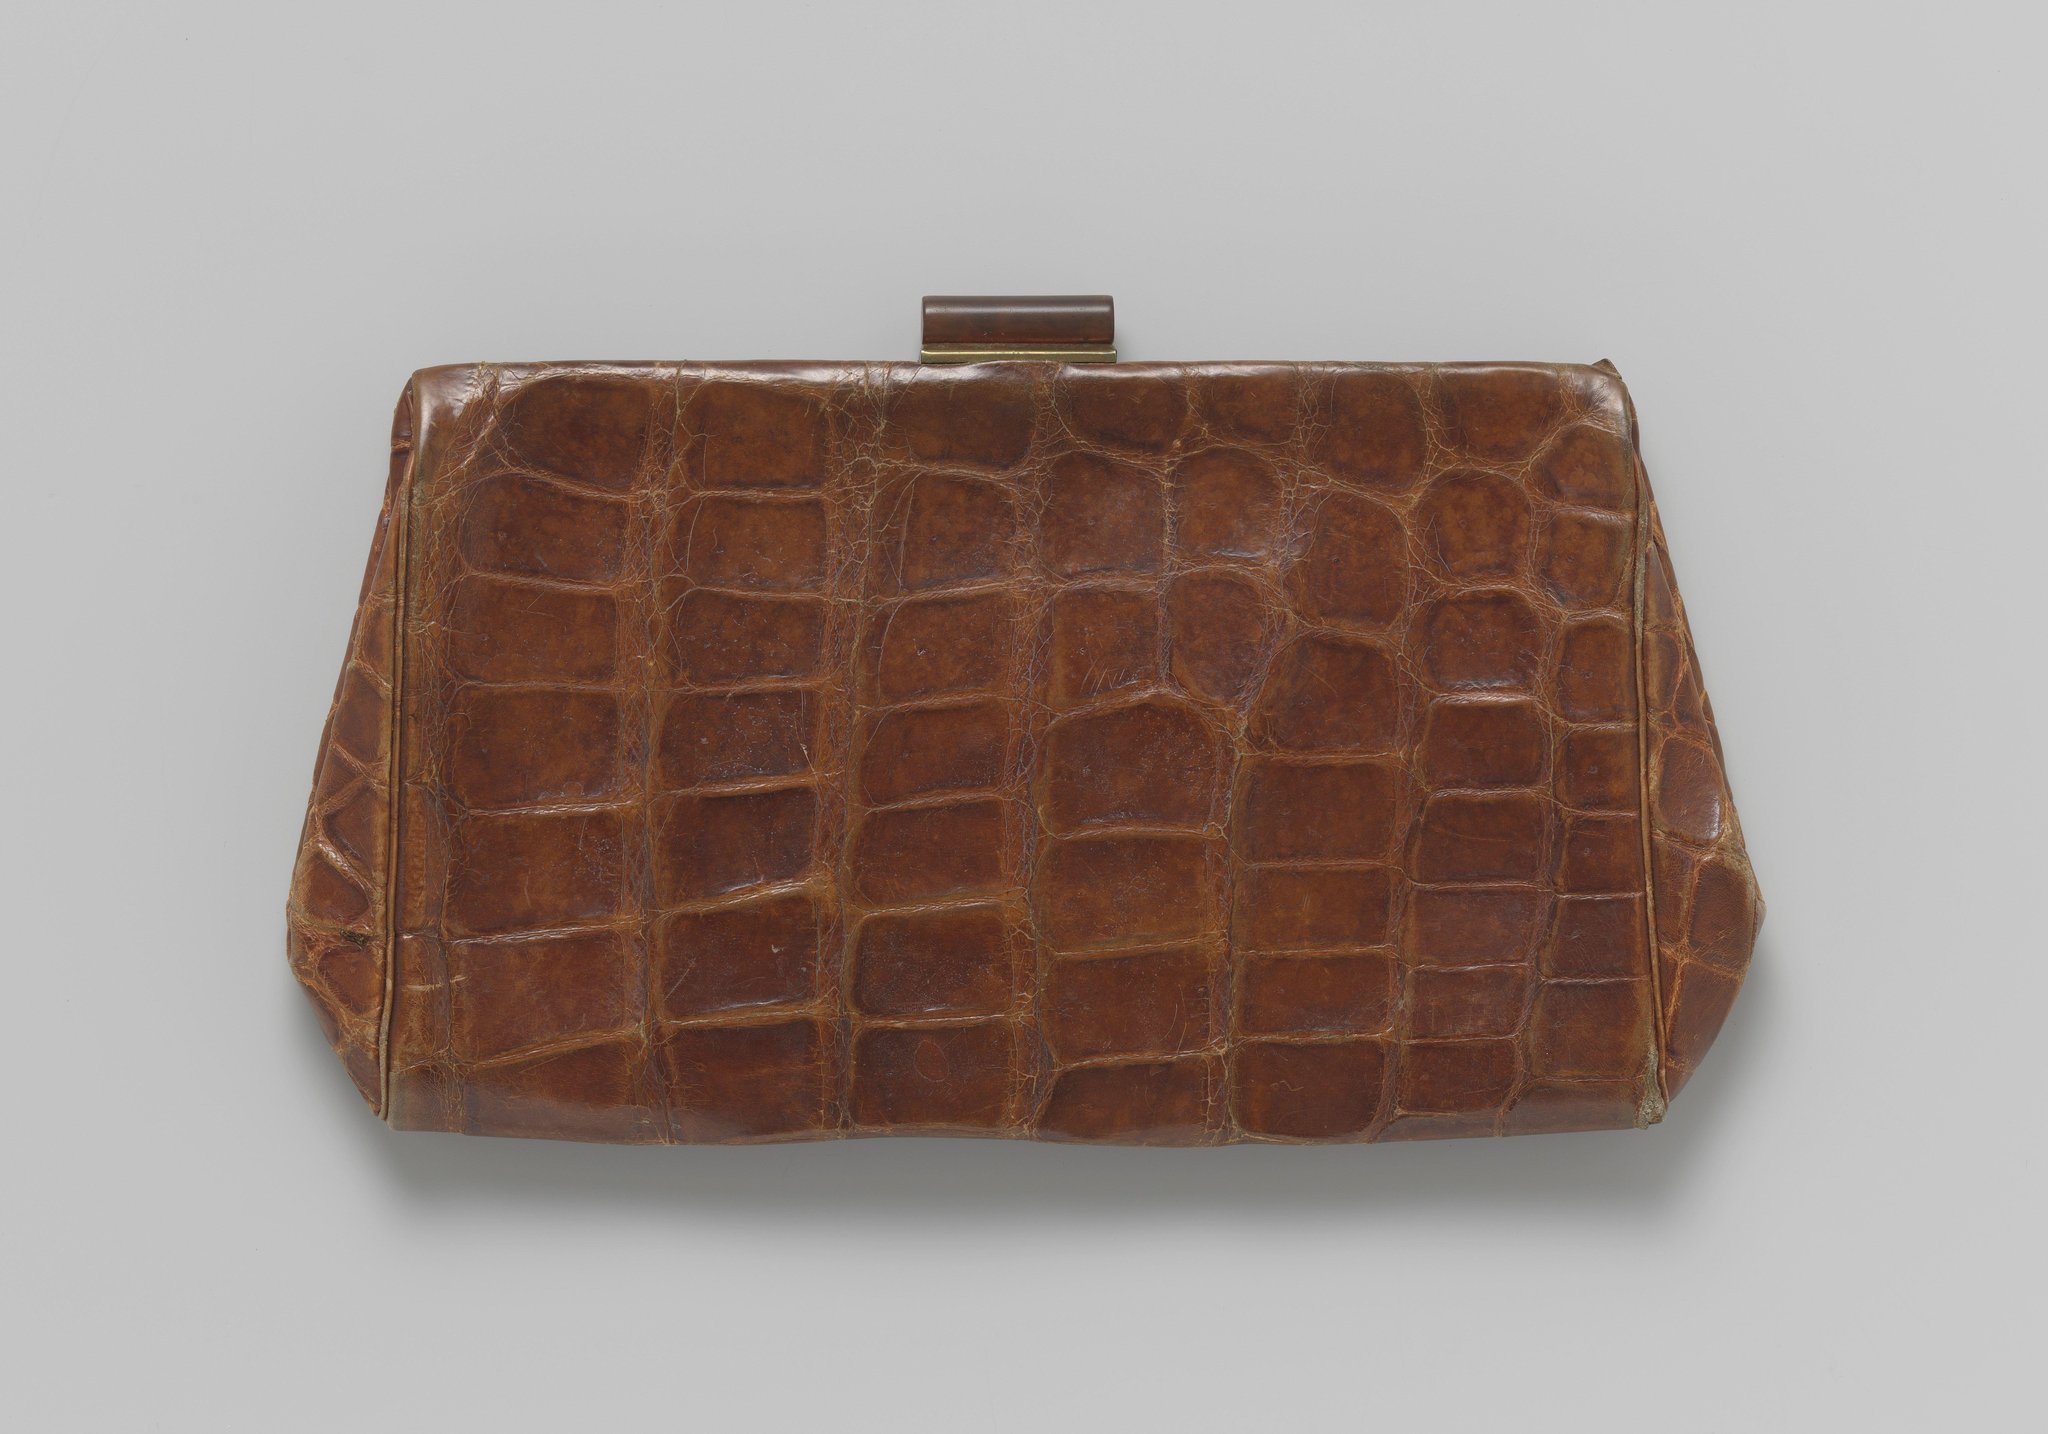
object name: beugeltas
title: Beugeltas van bruin leer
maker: Anonymous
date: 1910-1940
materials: leather, metal, textile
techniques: lining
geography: europe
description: De tas is van binnen met lichtbruin glanzend textiel gevoerd.